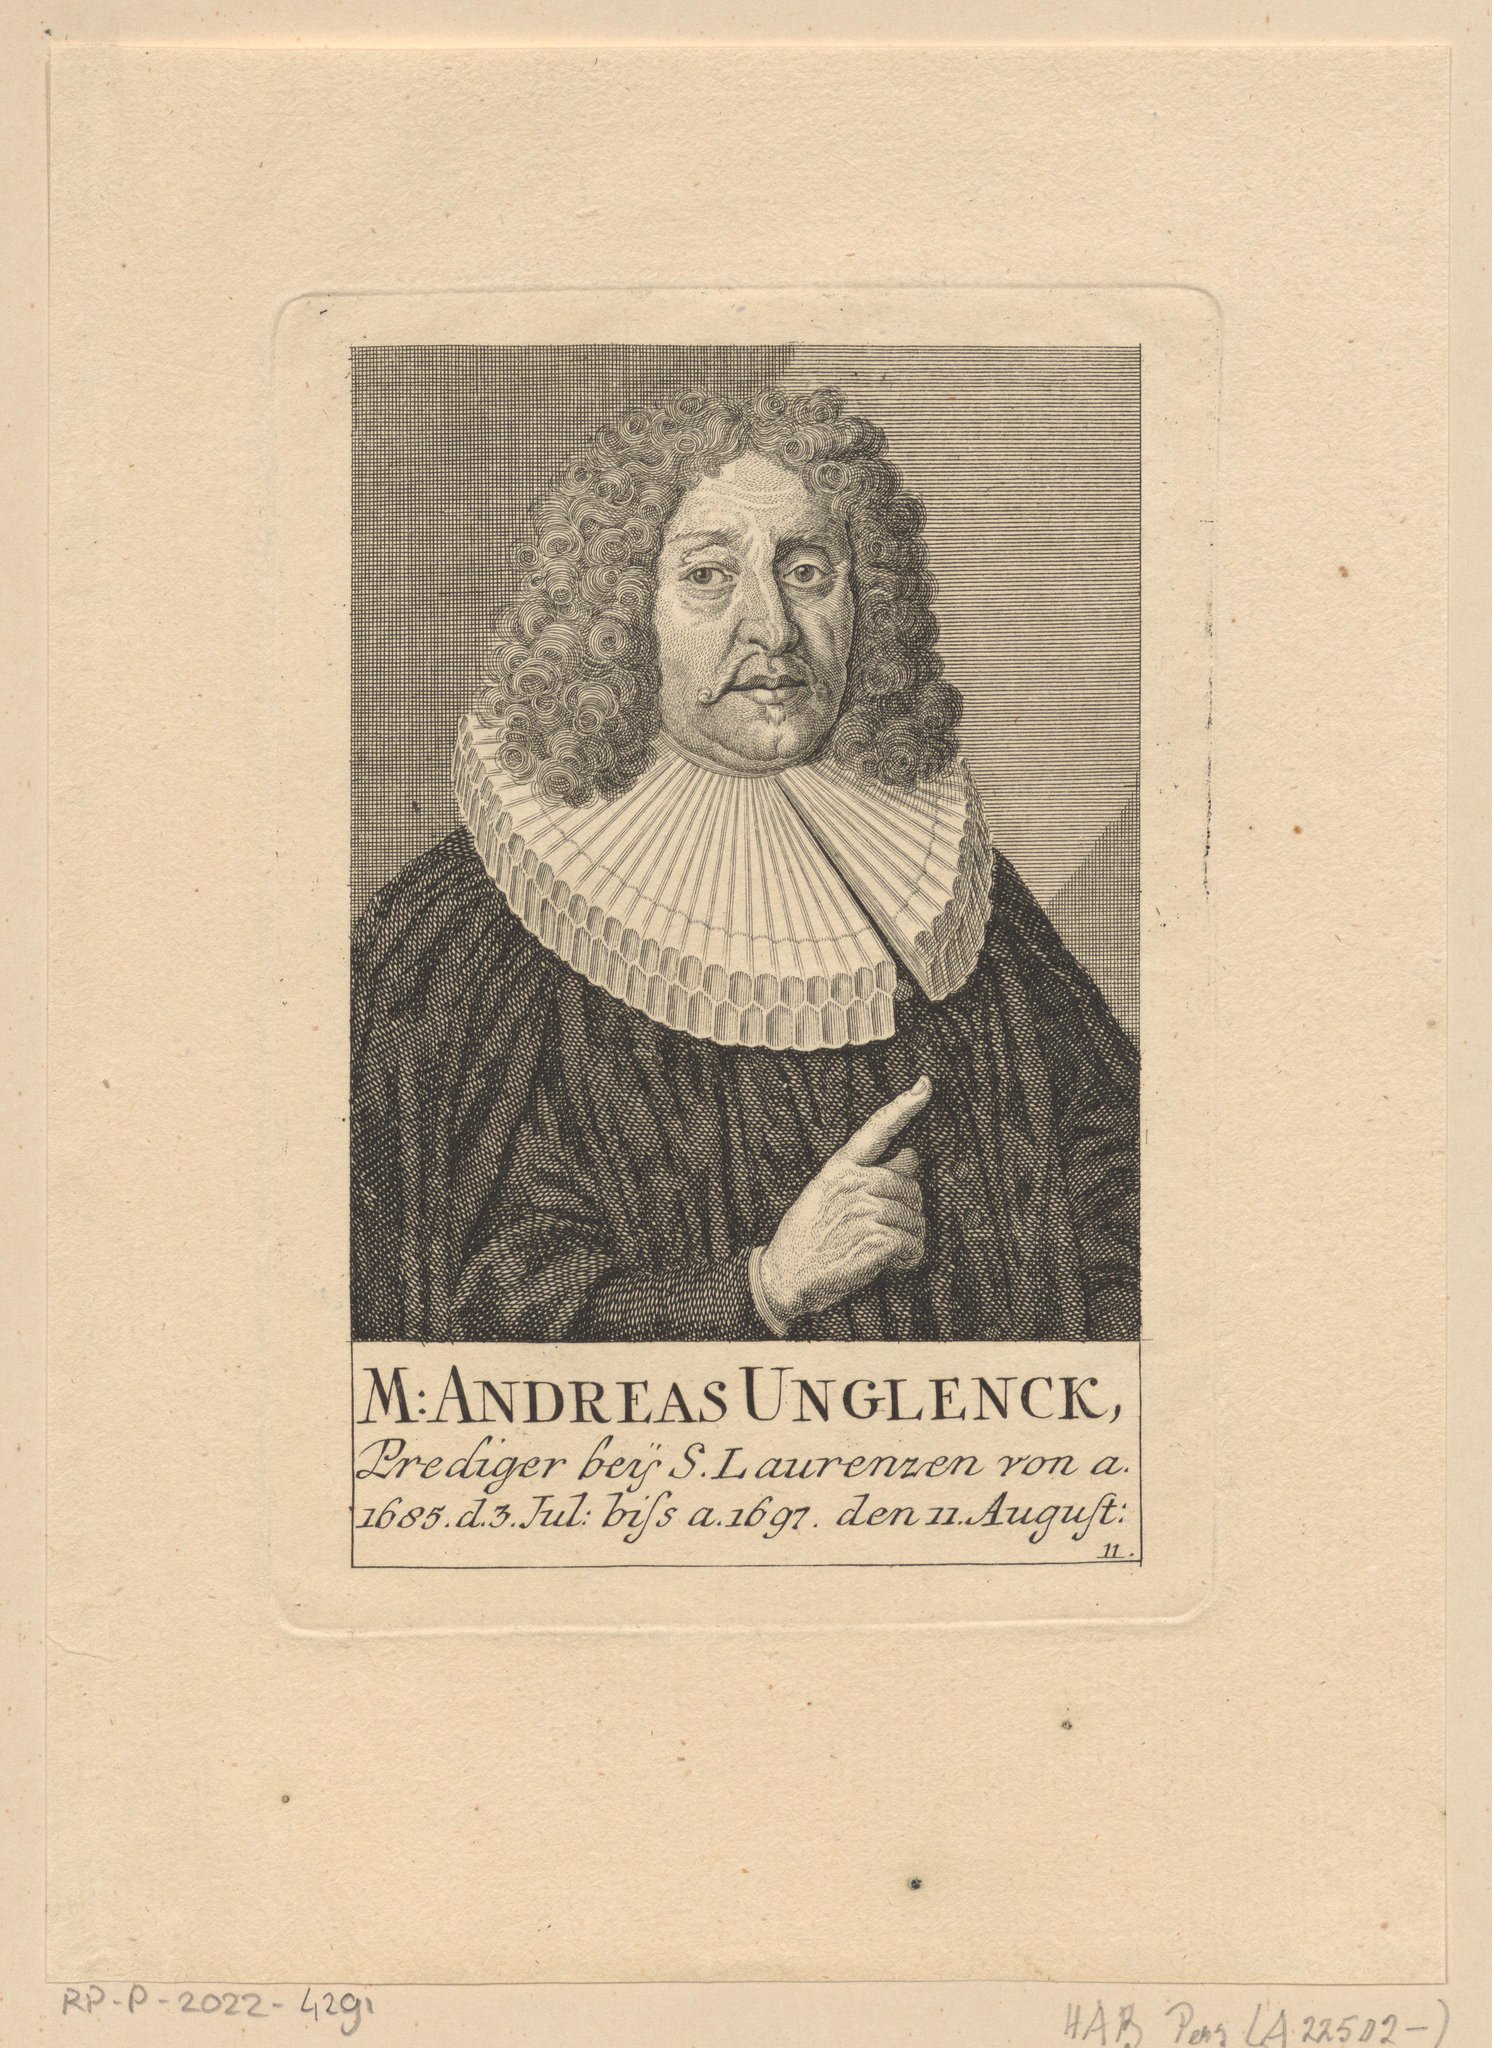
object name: book illustration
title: Portret van Andreas Unglenk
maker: christoph melchior roth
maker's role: print maker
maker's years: 1720-1798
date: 1756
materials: paper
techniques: engraving, etching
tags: theologian, historical persons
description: Prent waarschijnlijk uit: Würfel, Andreas. Diptycha ecclesiae Laurentianae (...). Neurenberg: Christoph Melchior Roth, 1756.